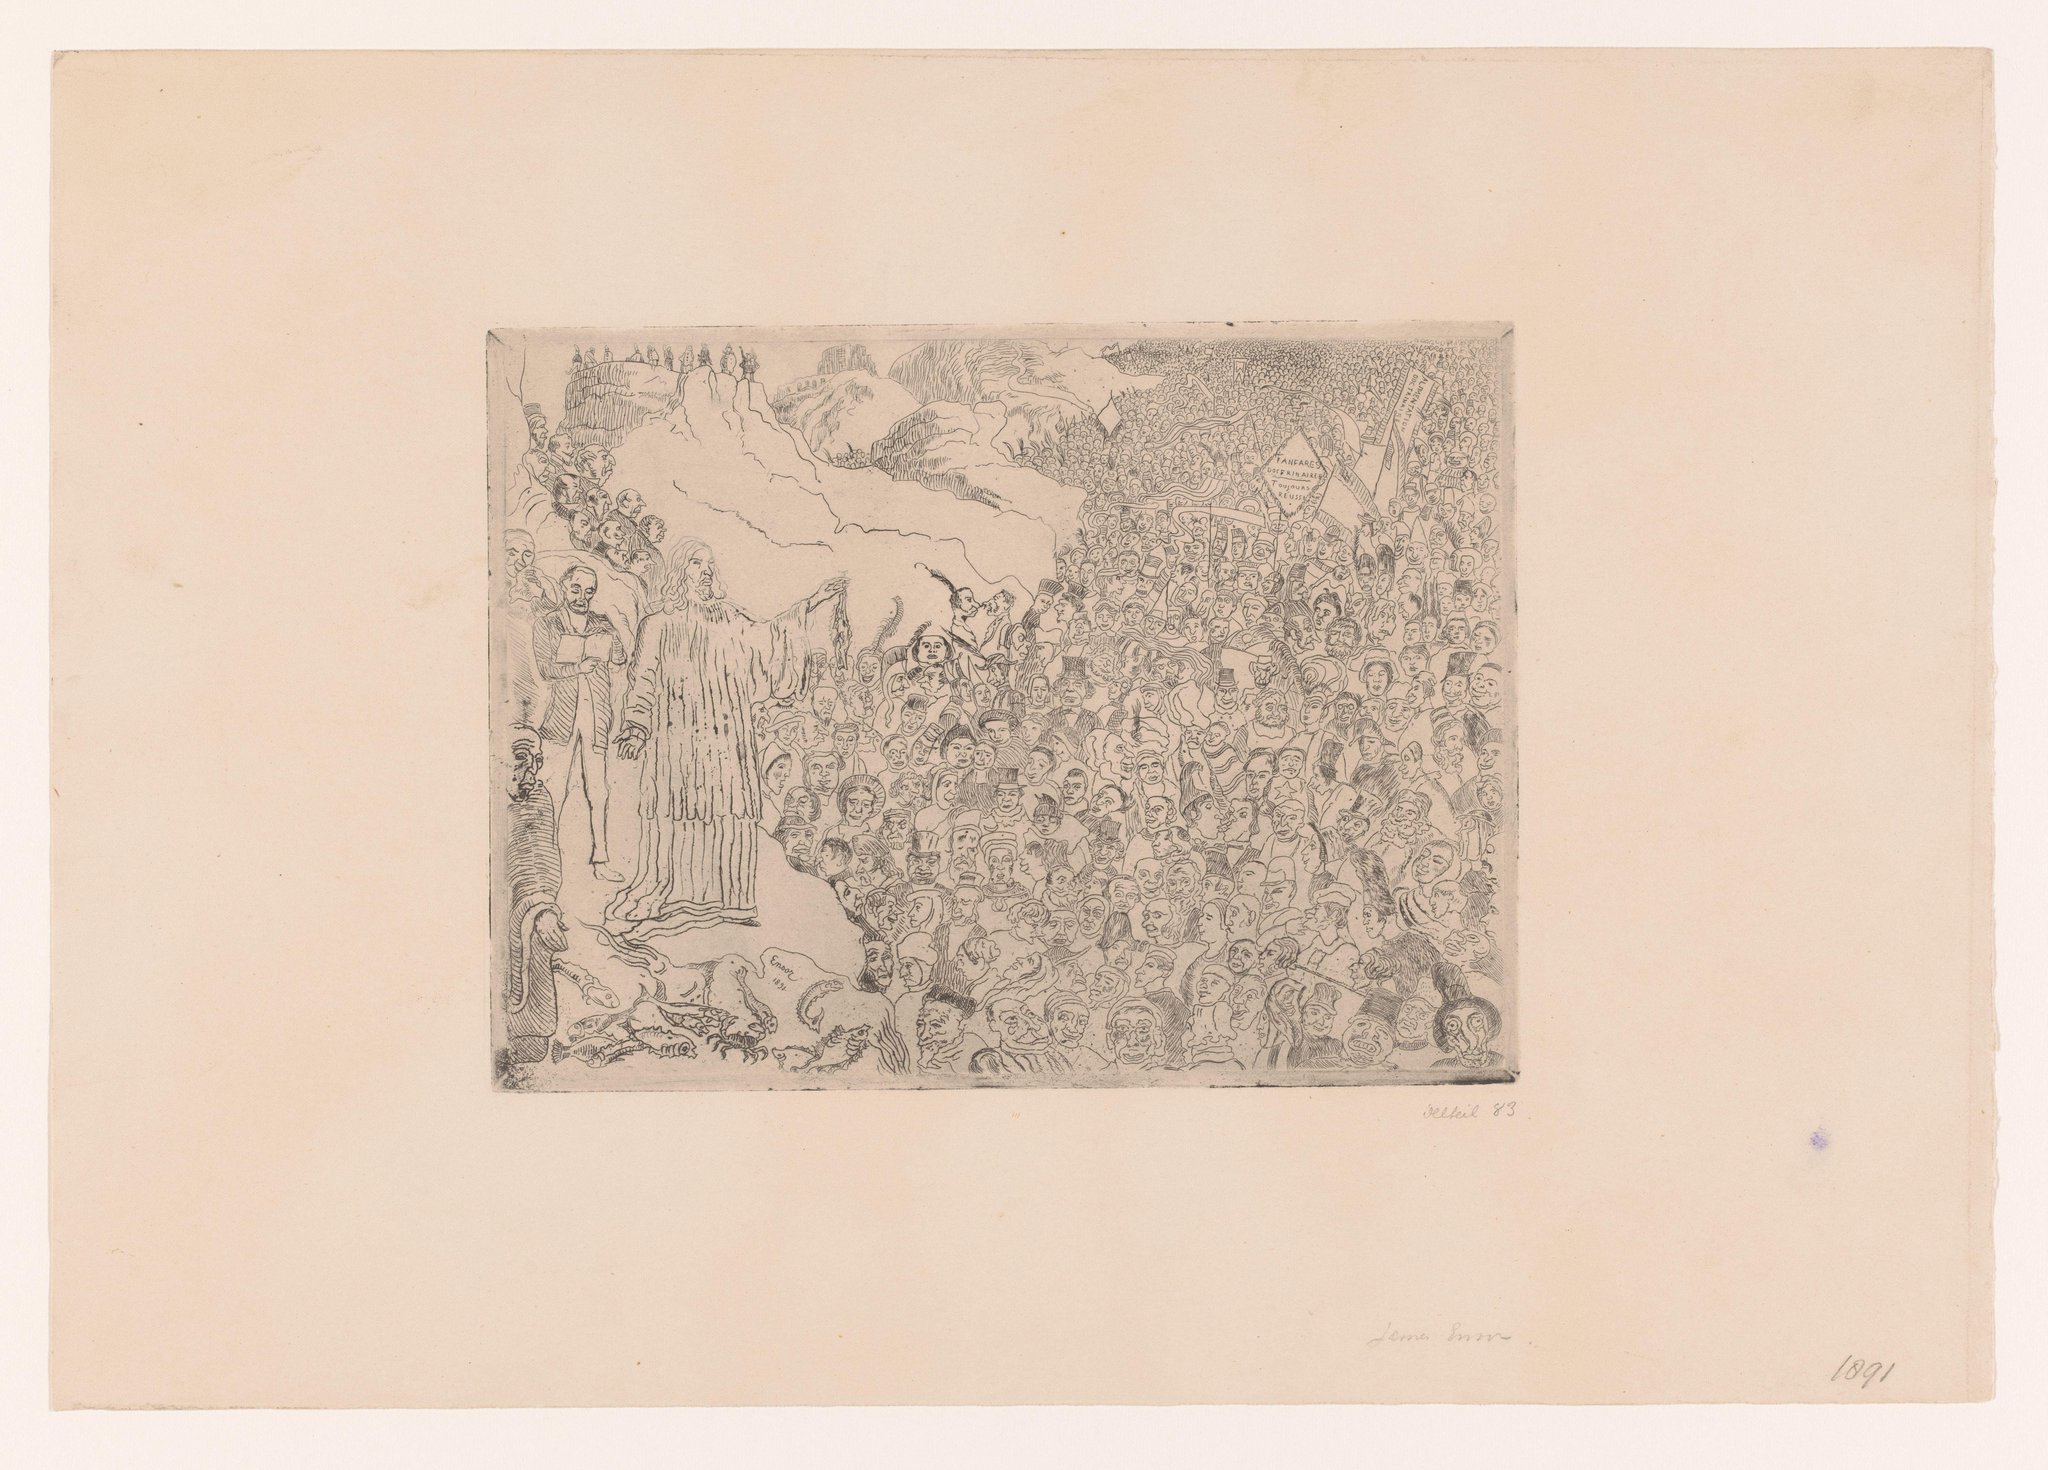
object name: cartoon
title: Vermenigvuldiging van vissen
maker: james ensor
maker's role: print maker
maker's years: 1860-1949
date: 1891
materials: paper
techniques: etching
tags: multiplication of loaves and fishes for a multitude of four or five thousand people (matthew 14:13-21, 15:32-39; mark 6:32-44, 8:1-10; luke 9:10-17; john 6:1-14)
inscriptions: collector's mark: Lugt 2228